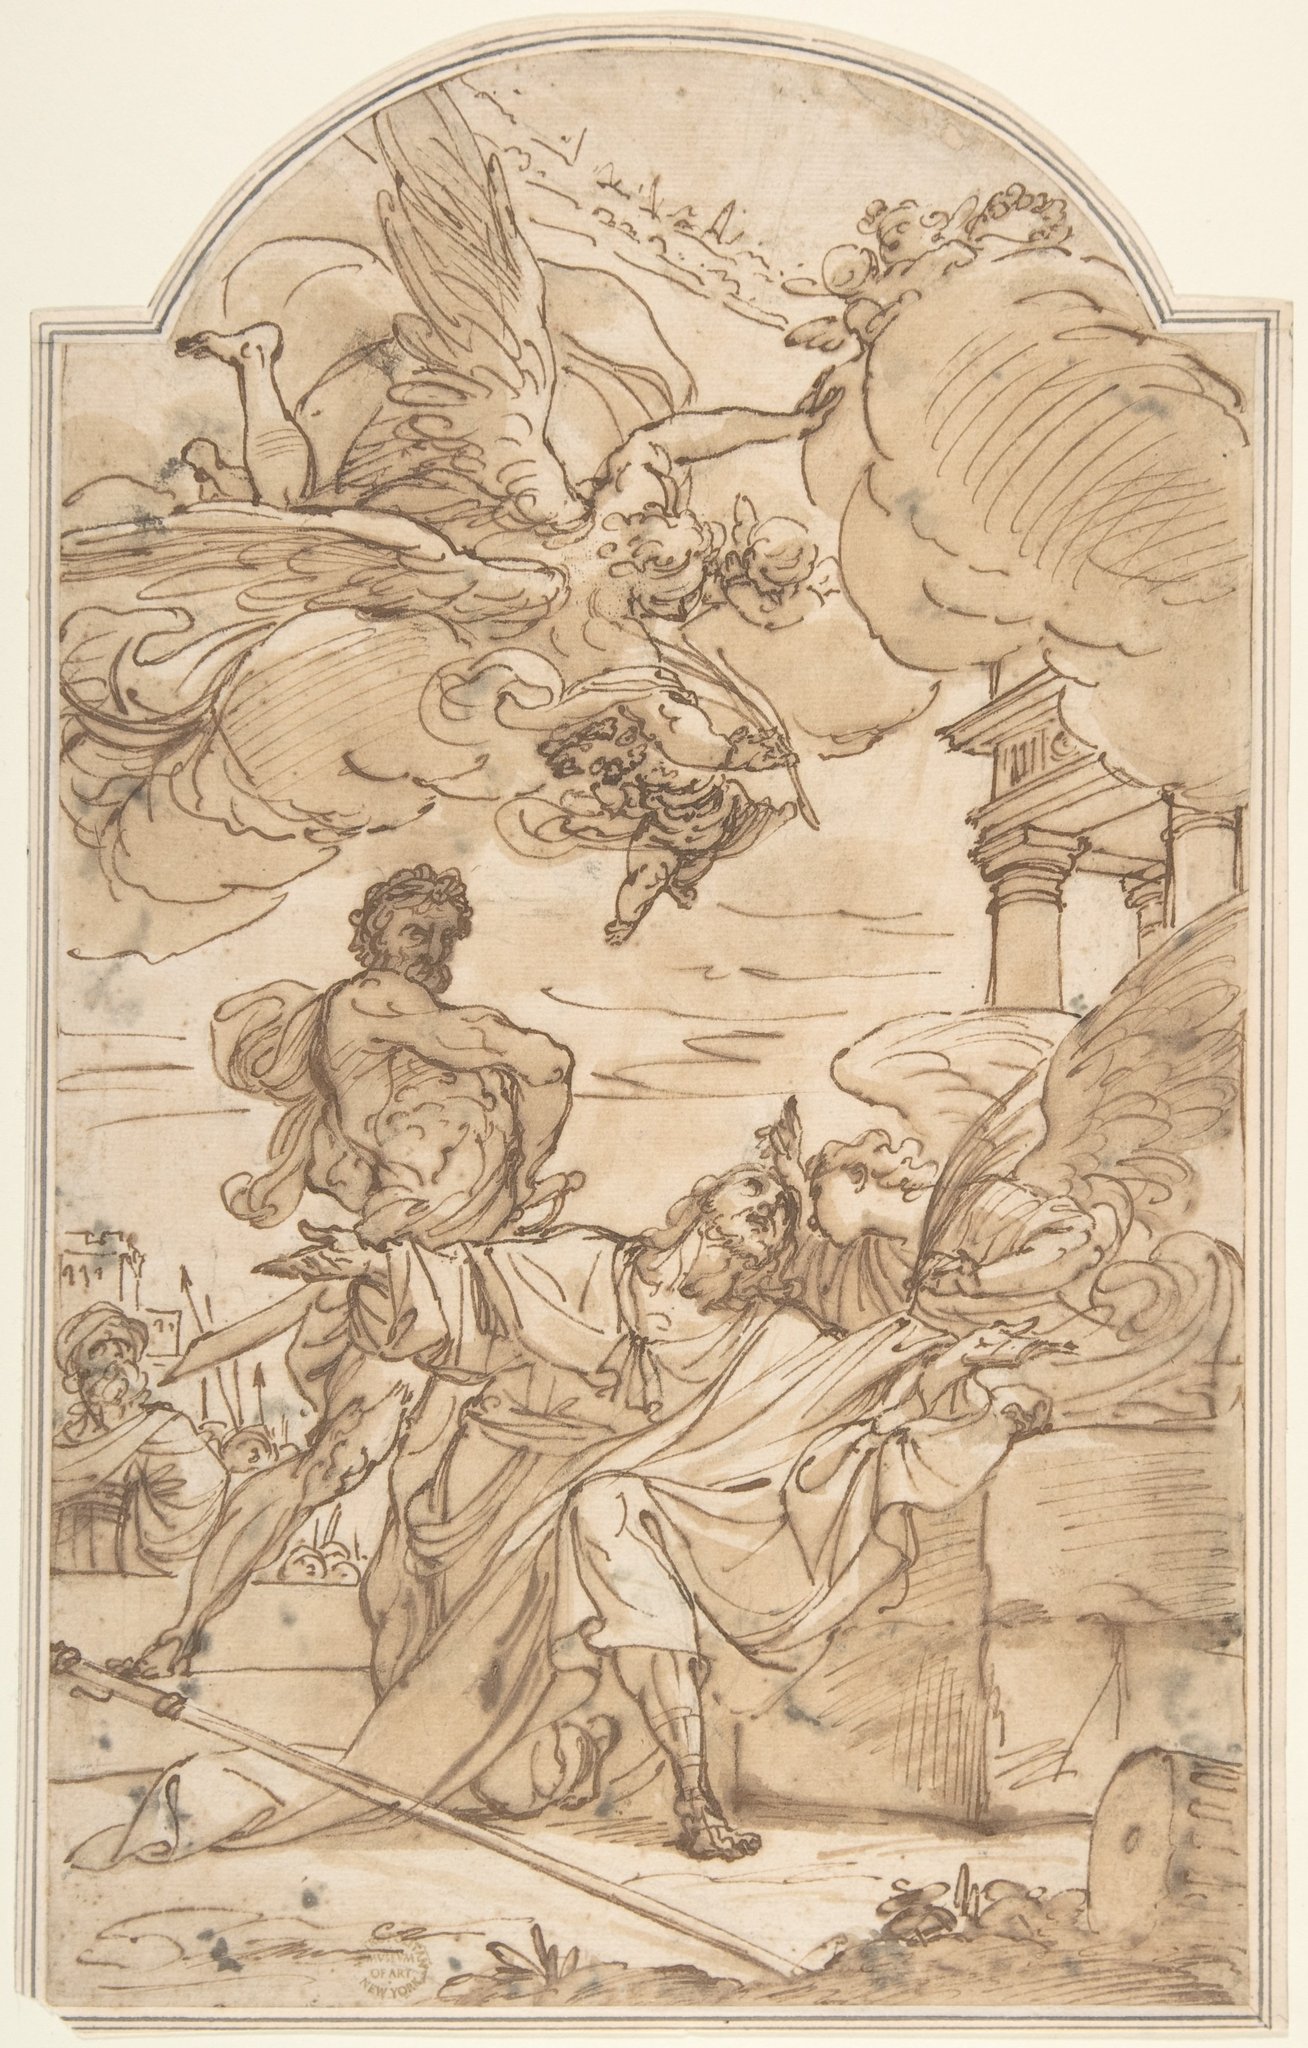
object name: drawing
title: Decapitation of Saint James the Greater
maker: ubaldo gandolfi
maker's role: artist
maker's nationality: italian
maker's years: 1728-1781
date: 1728-1781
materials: chalk, ink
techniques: brush, pen, wash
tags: angels,saints